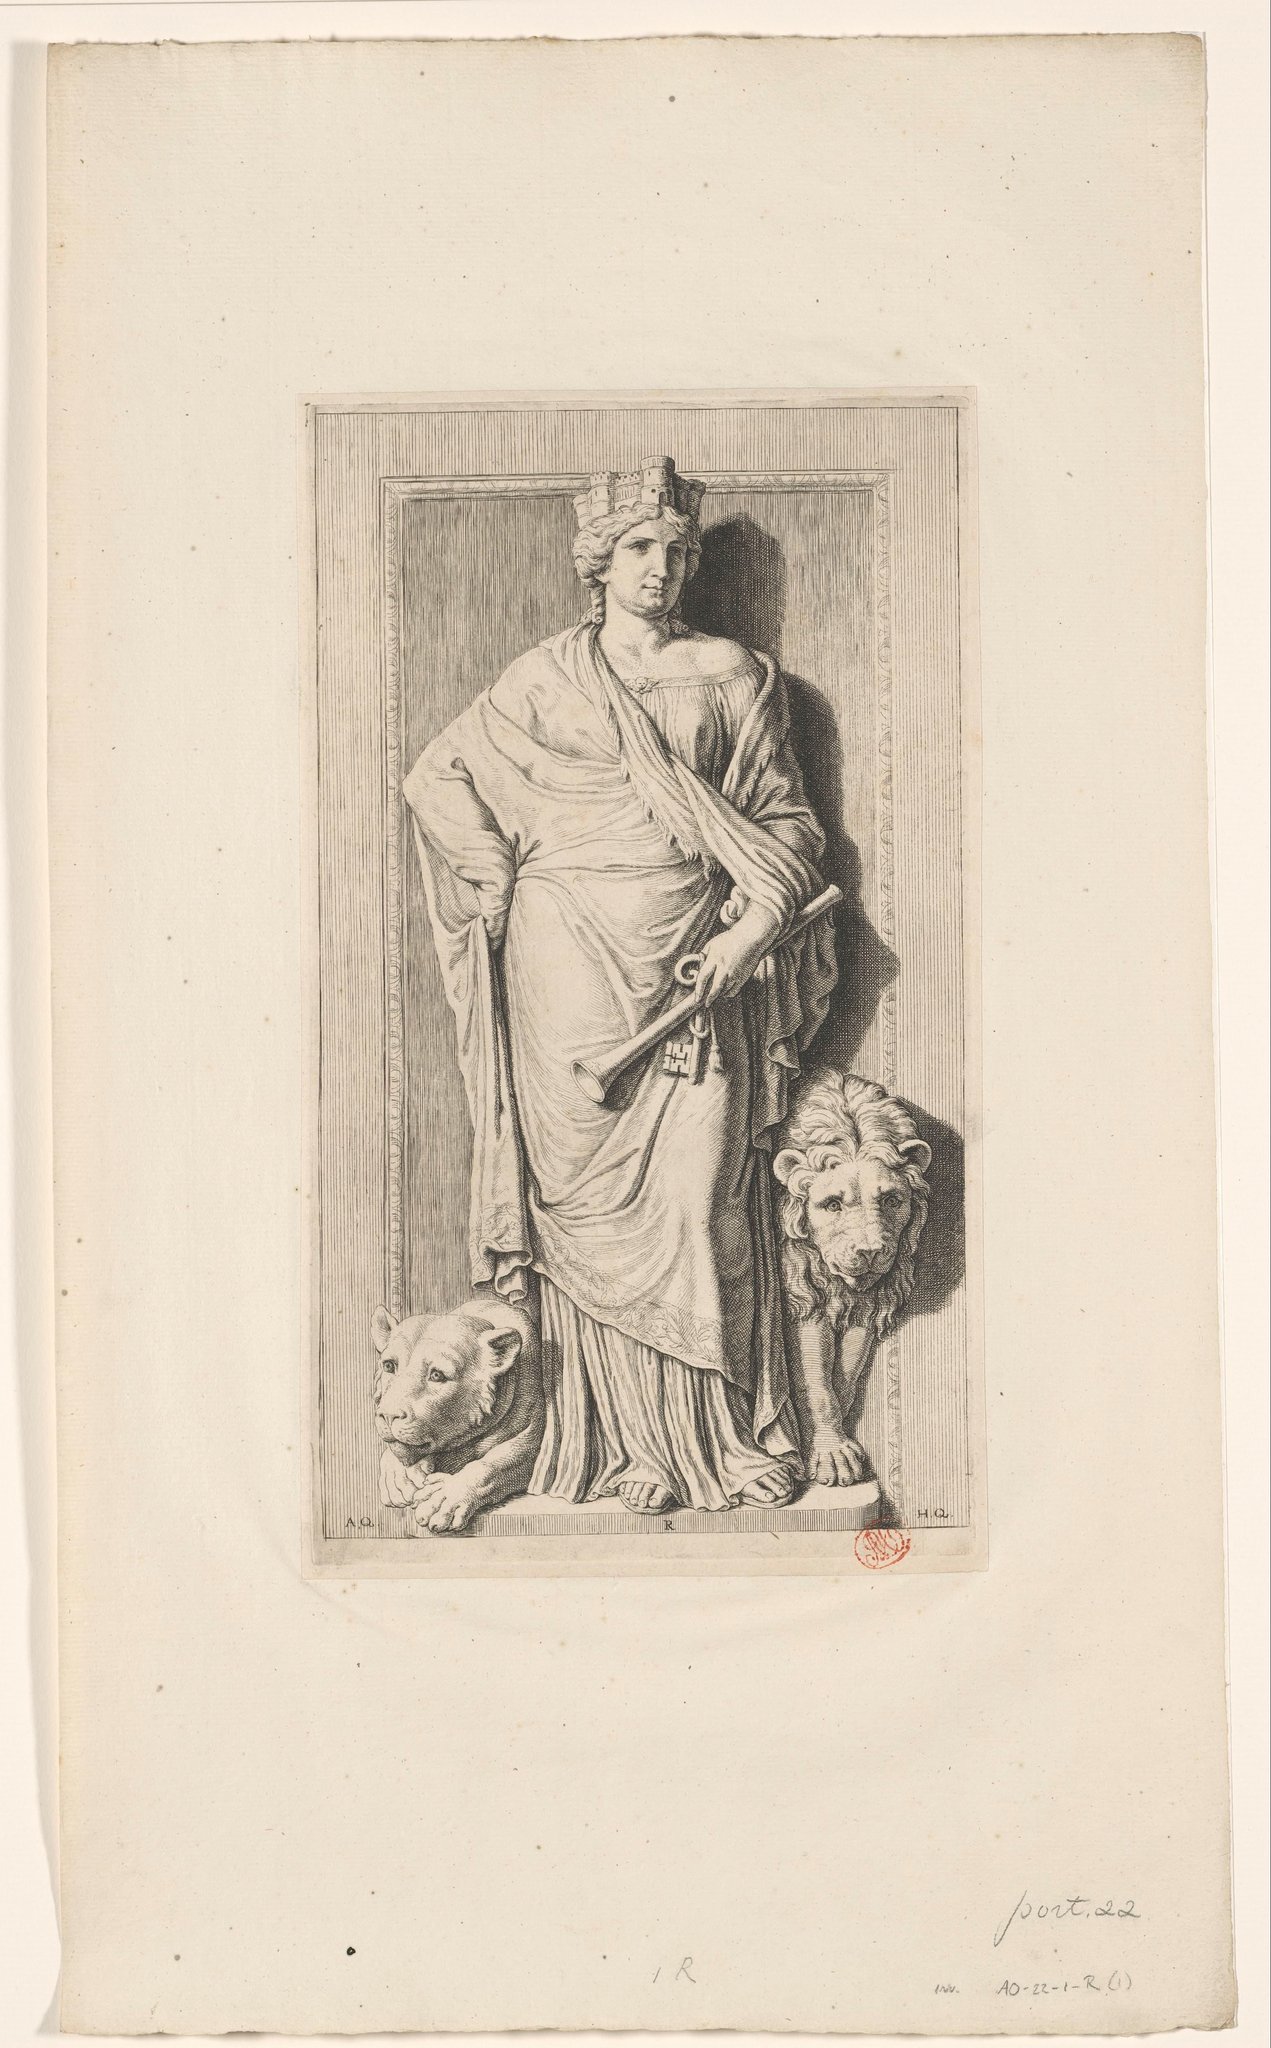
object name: book illustration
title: Beeld van Cybele in de oostelijke galerij van het Stadhuis op de Dam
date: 1655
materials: paper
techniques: engraving, etching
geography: amsterdam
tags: (story of) cybele, rhea cybele, great mother of the gods (berecynt(h)ia), beasts of prey, predatory animals: lion, attributes of cybele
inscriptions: collector's mark: Lugt 195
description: Prent gebruikt in: Prima pars. Praecipuarum effigierum ac ornamentorum, amplissimae Curiae Amstelrodamensis (…) / Het eerste deel. Van de voornaemste Statuen ende Ciraten, vant konstijck Stadhuys van Amstelredam, tmeeste in marmer gemaeckt, door Artus Quellinus, Beelthouwer der voorseyde Stadt / La Premier Partie. De plusieurs Figures et ornements, de la Maison de Ville d'Amsterdam (…). Amsterdam: Artus Quellinus (I), 1655. Zie RP-P-AO-22-1-1 voor bijhorende titelpagina. Zie RP-P-AO-22-1-2 voor bijhorend register. Zie RP-P-AO-22-1A, RP-P-AO-22-1B, RP-P-AO-22-1C, RP-P-AO-22-1D-1, RP-P-AO-22-1D-2, RP-P-AO-22-1E, RP-P-AO-22-1F, RP-P-AO-22-1G, RP-P-AO-22-1H, RP-P-AO-22-1I, RP-P-AO-22-1K-1, RP-P-AO-22-1K-2, RP-P-AO-22-1K-3, RP-P-AO-22-1K-4, RP-P-AO-22-1K-5, RP-P-AO-22-1L-1, RP-P-AO-22-1L-2, RP-P-AO-22-1M-1, RP-P-AO-22-1M-2, RP-P-AO-22-1N-1, RP-P-AO-22-1N-2, RP-P-AO-22-1N-3, RP-P-AO-22-1N-4, RP-P-AO-22-1N-5, RP-P-AO-22-1O-1, RP-P-AO-22-1O-2, RP-P-AO-22-1O-3, RP-P-AO-22-1O-4, RP-P-AO-22-1P-1, RP-P-AO-22-1P-2, RP-P-AO-22-1P-3, RP-P-AO-22-1P-4, RP-P-AO-22-1Q-1, RP-P-AO-22-1Q-2, RP-P-AO-22-1Q-3, RP-P-AO-22-1Q-4, RP-P-AO-22-1R-2, RP-P-AO-22-1R-3, RP-P-AO-22-1R-4, RP-P-AO-22-1R-5, RP-P-AO-22-1S-1, RP-P-AO-22-1S-2, RP-P-AO-22-1S-3, RP-P-AO-22-1S-4, RP-P-AO-22-1S-5, RP-P-AO-22-1T-1 en RP-P-AO-22-1T-2 voor andere prenten uit deze publicatie. Zelfde staat van prent ook gebruikt in: Prima pars. Praecipuarum effigierum ac ornamentorum, amplissimae Curiae Amstelrodamensis (…) / Het eerste deel. Van de voornaemste Statuen ende Ciraten, vant konstijck Stadhuys van Amstelredam, tmeeste in marmer gemaeckt, door Artus Quellinus, Beelthouwer der voorseyde Stadt / La Premier Partie. De plusieurs Figures et ornements, de la Maison de Ville d'Amsterdam (…). Amsterdam: Frederik de Wit, 1665. Latere staat van prent ook gebruikt in: Architecture peinture et sculpture de la Maison de Ville d'Amsterdam, representee en CIX. figures en taille-douce (…). Amsterdam: David Mortier, 1719. En in: Architecture peinture et sculpture de la Maison de Ville d'Amsterdam, representee en CIX. figures en taille-douce (…). Amsterdam: Gerard Valck, 1719. En in: Bouw schilder en beeldhouwkonst, van het Stadhuis te Amsteldam, vertoont in CIX figuuren (…). Amsterdam: Covens & Mortier & Covens Jr., s.a. (1774-1783). Zie BK-AM-51-18 voor model van beeld.